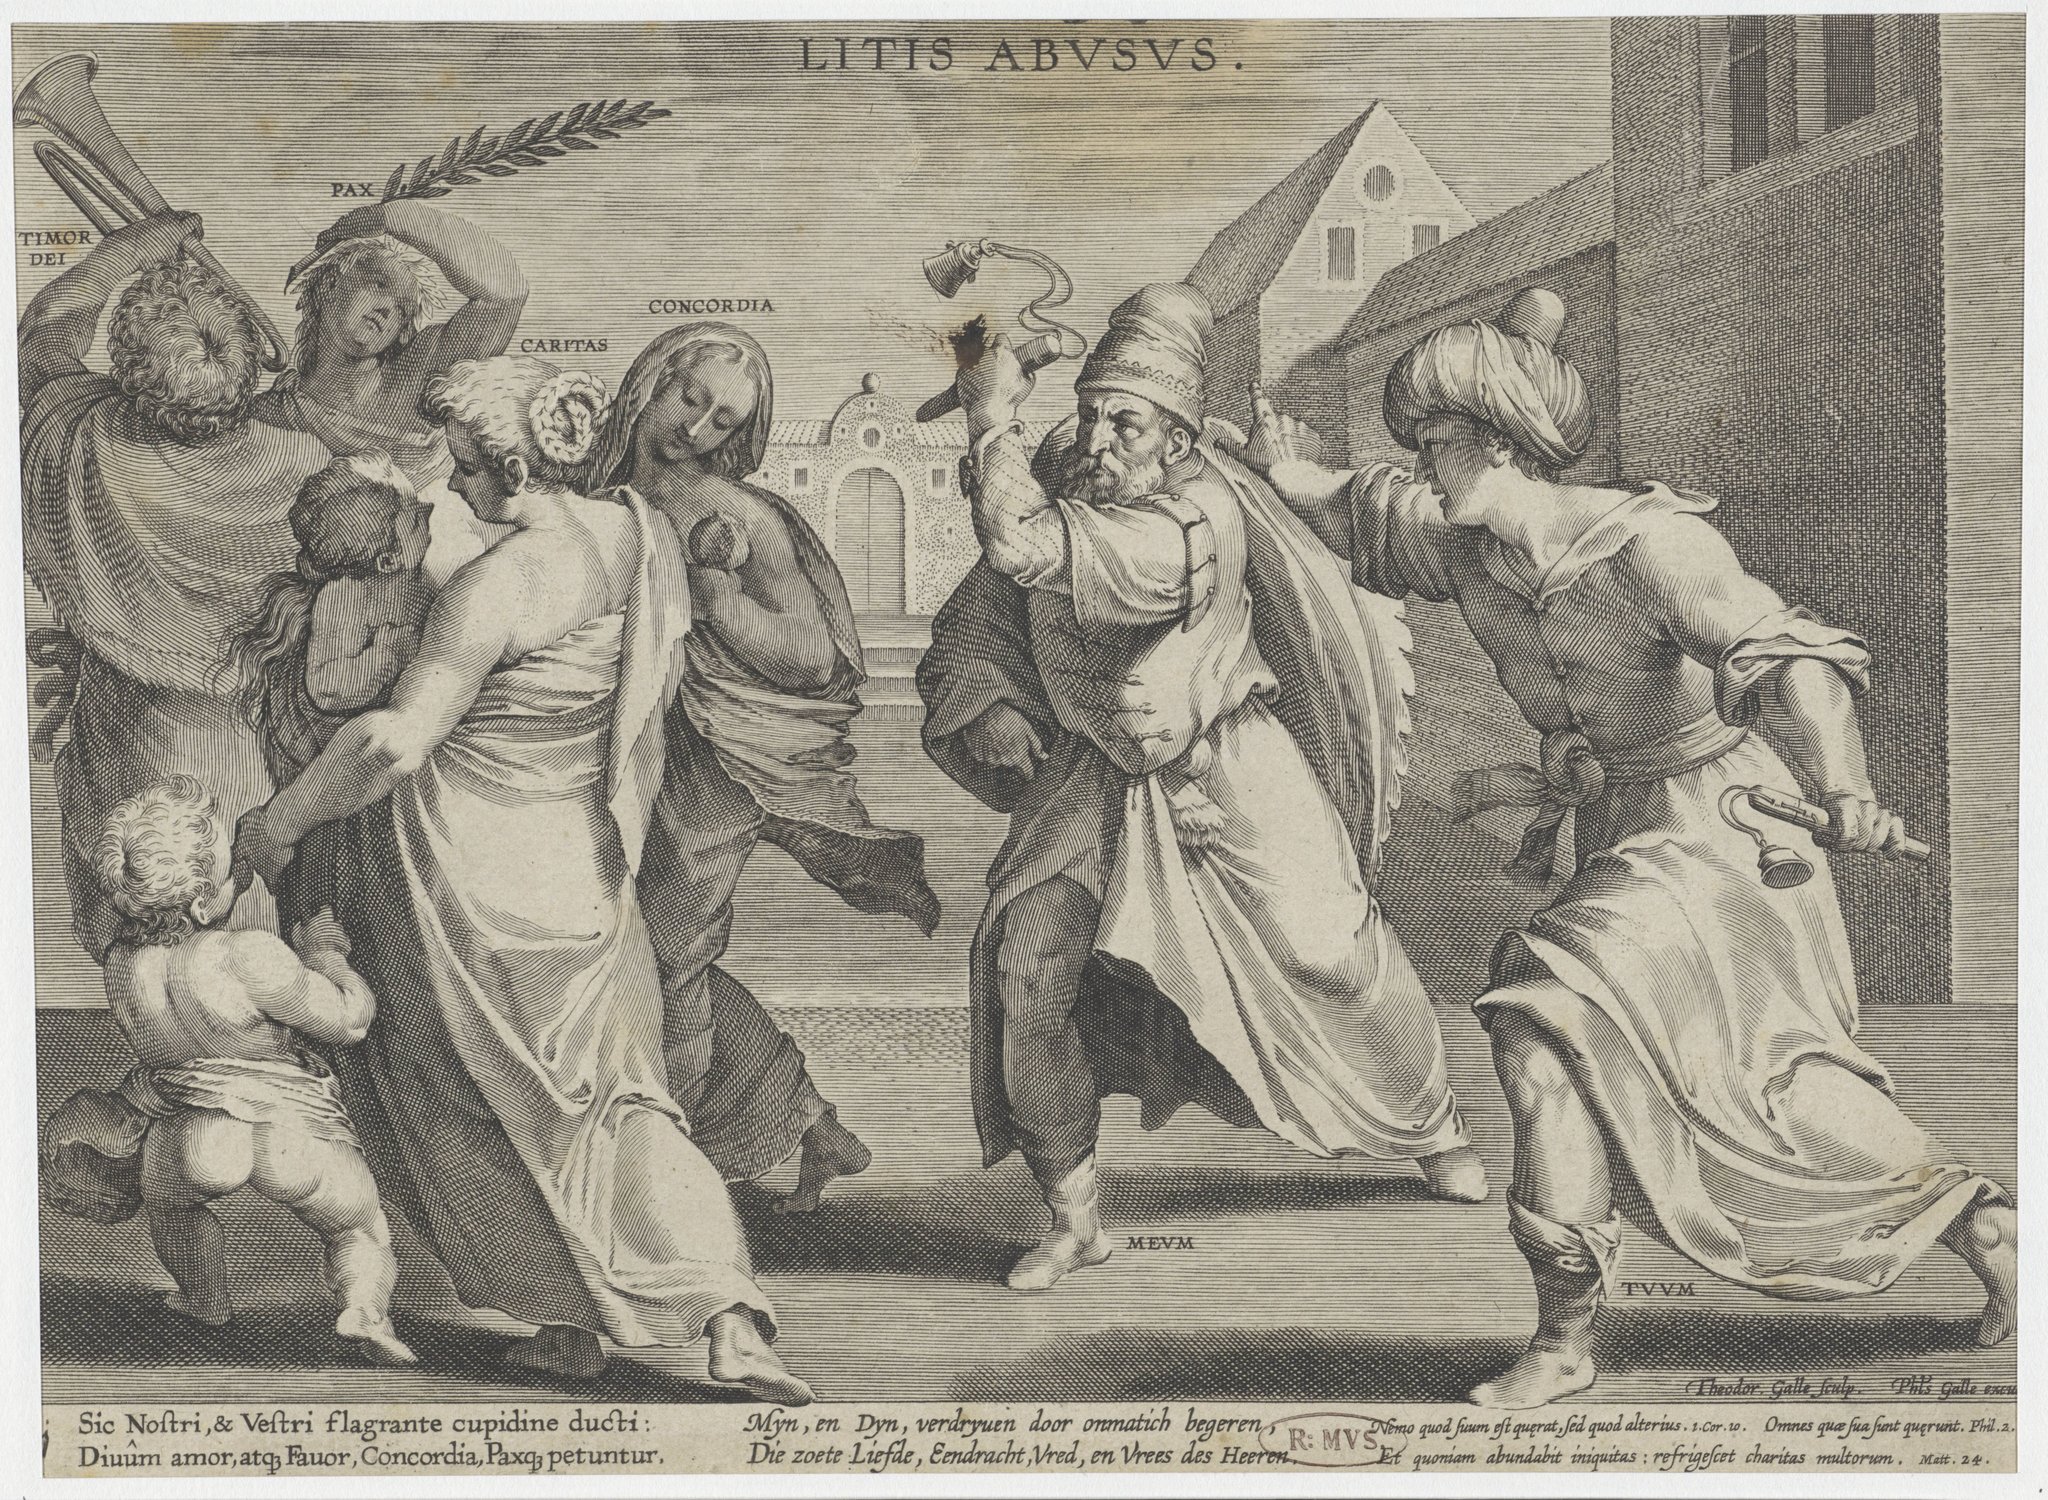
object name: print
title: Egoïsme bedreigt de deugden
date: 1593-1597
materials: paper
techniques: engraving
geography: antwerp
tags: agreement, unity; 'concordia', 'concordia insuperabile', 'concordia militare', 'concordia di pace', 'unione civile' (ripa), charity, 'caritas'; 'carità' (ripa) ~ one of the three theological virtues, symbols, allegories of peace, 'pax'; 'pace' (ripa), piety, 'pietas', 'timor dei' ~ the three theological virtues, greed, covetousness, cupidity; 'cupidità' (ripa) (+ clothed)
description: De personificaties van de deugden Naastenliefde (Caritas), Eendracht (Concordia), Vrede (Pax) en Timor Dei (Godsvrucht) worden weggejaagd door de personificaties van Mijn (Meum) en Dijn (Tuum). Mijn en Dijn hebben zwepen in de hand. De prent heeft drie onderschriften (twee in het Latijn en een in het Nederlands) en maakt deel uit van een achtdelige serie over de misbruiken in procesvoering.